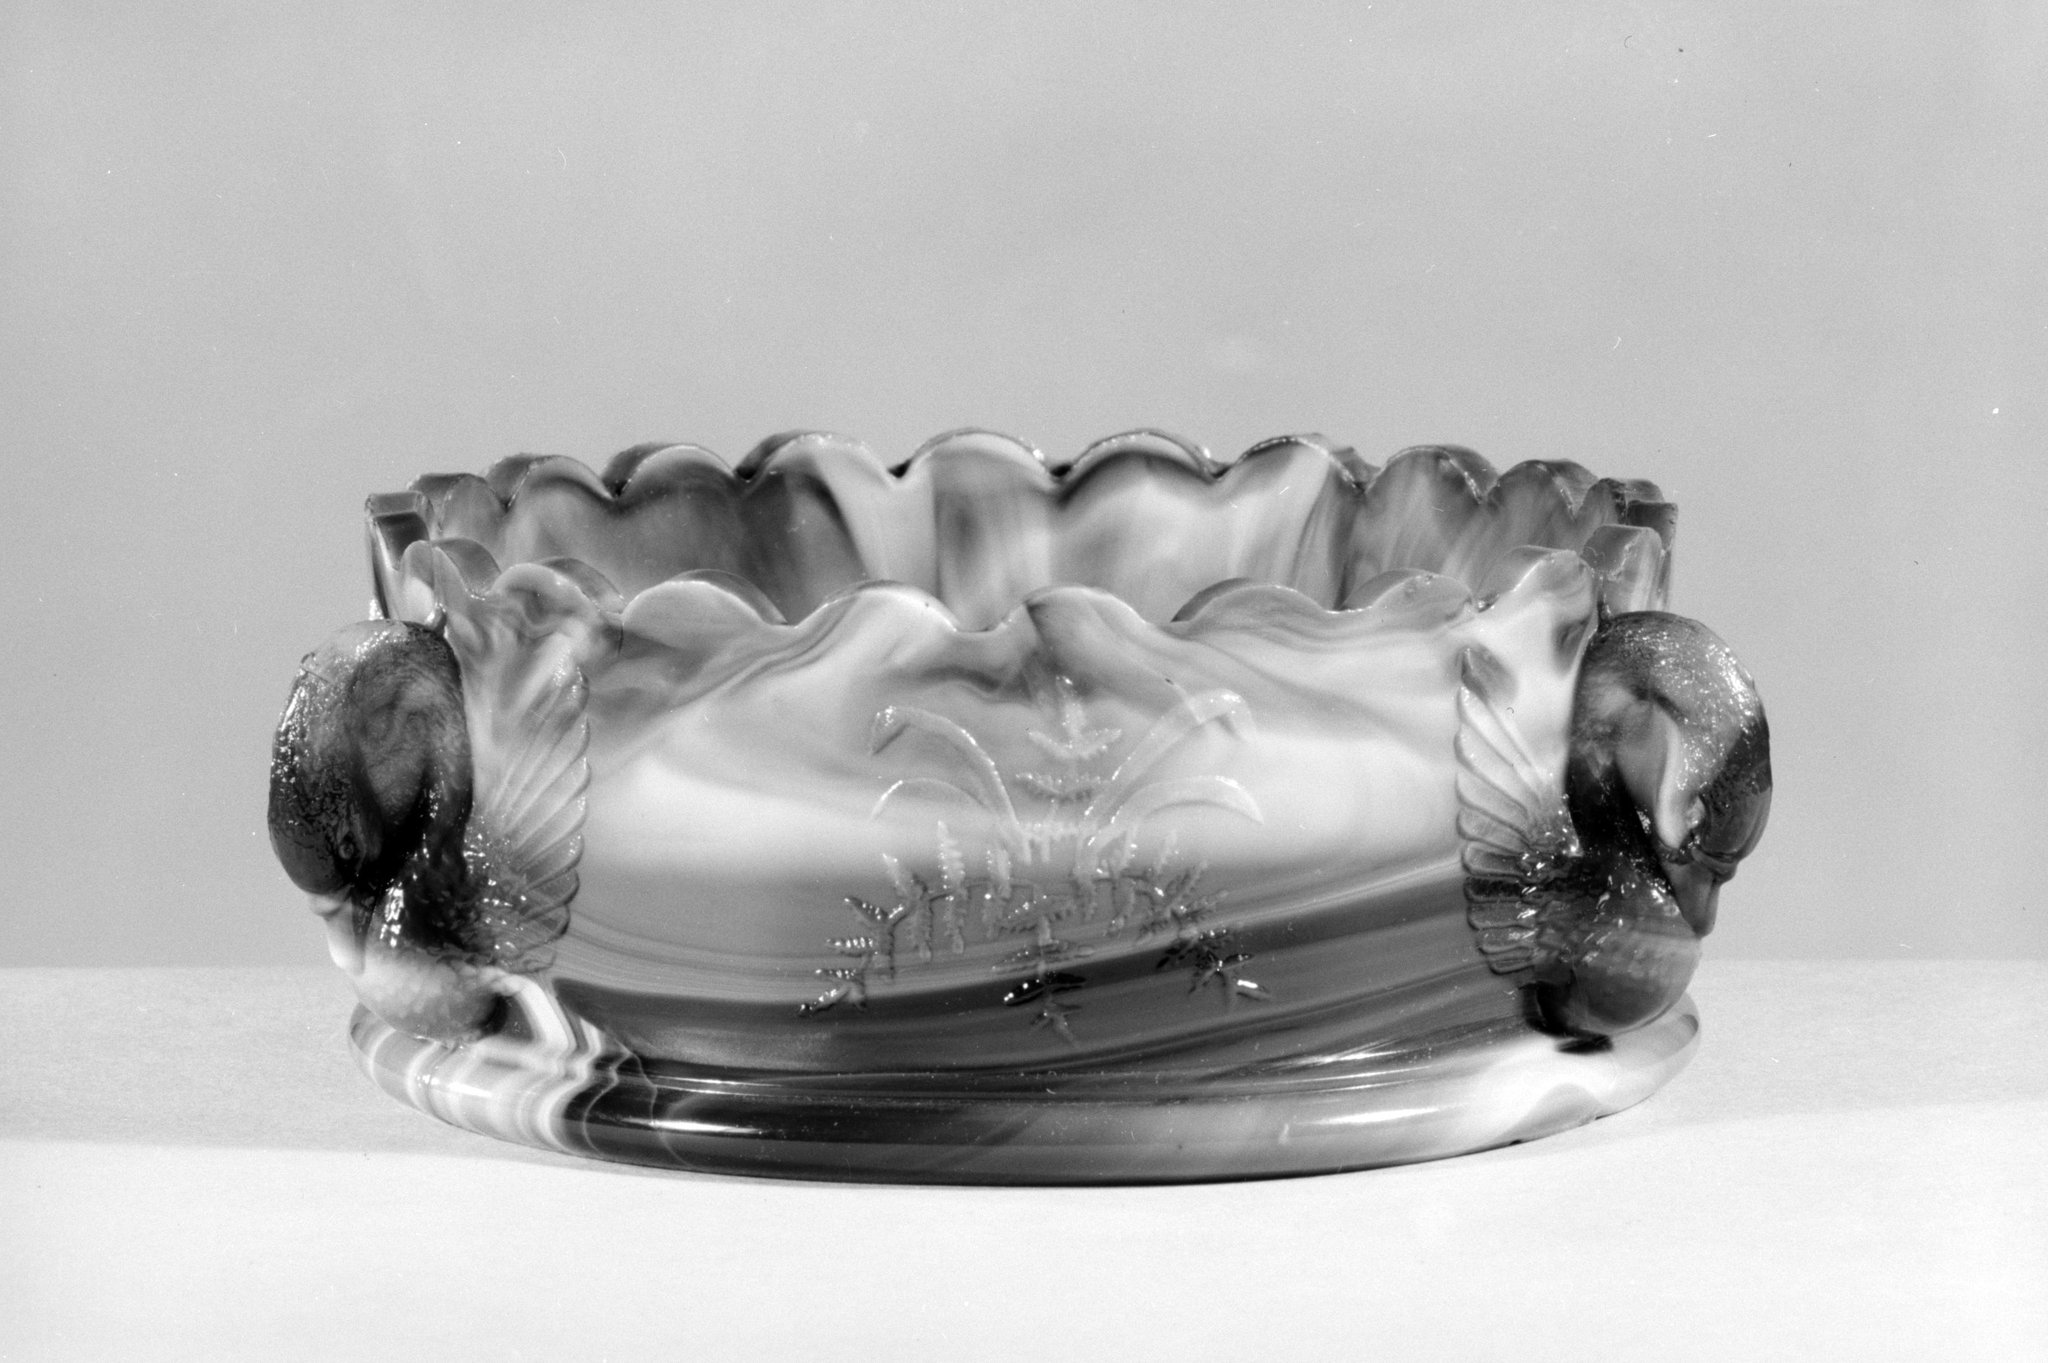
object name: bowl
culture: american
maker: challinor, taylor and company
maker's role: maker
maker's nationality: american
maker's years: 1866-1891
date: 1870-1890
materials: glass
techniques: pressed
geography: united states